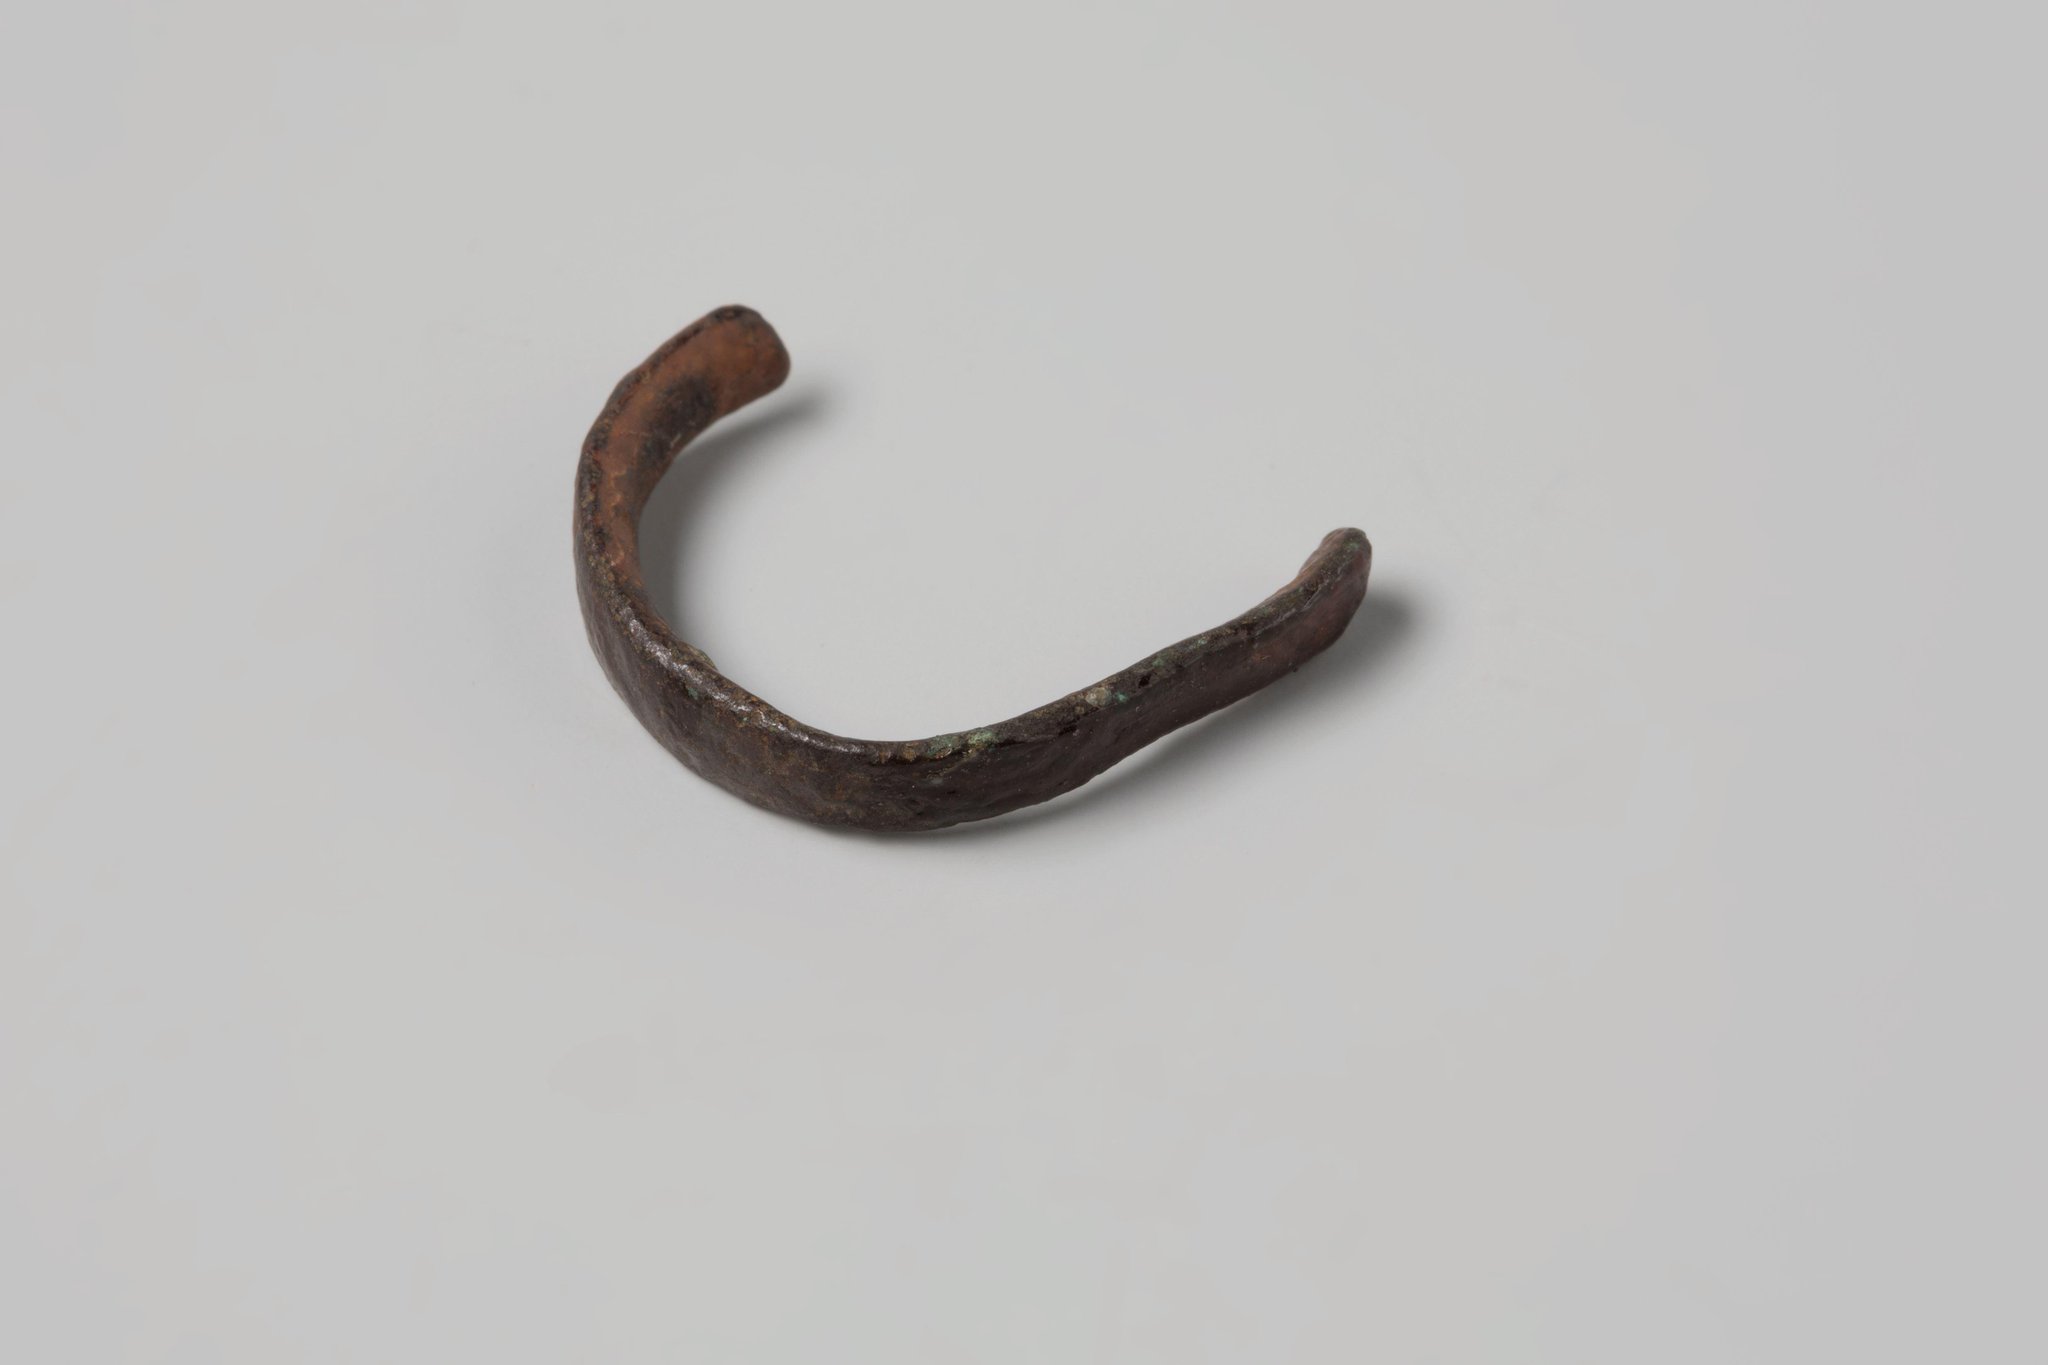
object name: pin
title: Fragment speld uit het wrak van de Oost-Indiëvaarder Hollandia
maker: Anonymous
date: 1700-1743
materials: copper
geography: netherlands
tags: verenigde oostindische compagnie, hollandia (schip), annet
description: Tools and instruments, sewing and sailmaking, pin; fragm of bow, id. NG 1980-27H3265.